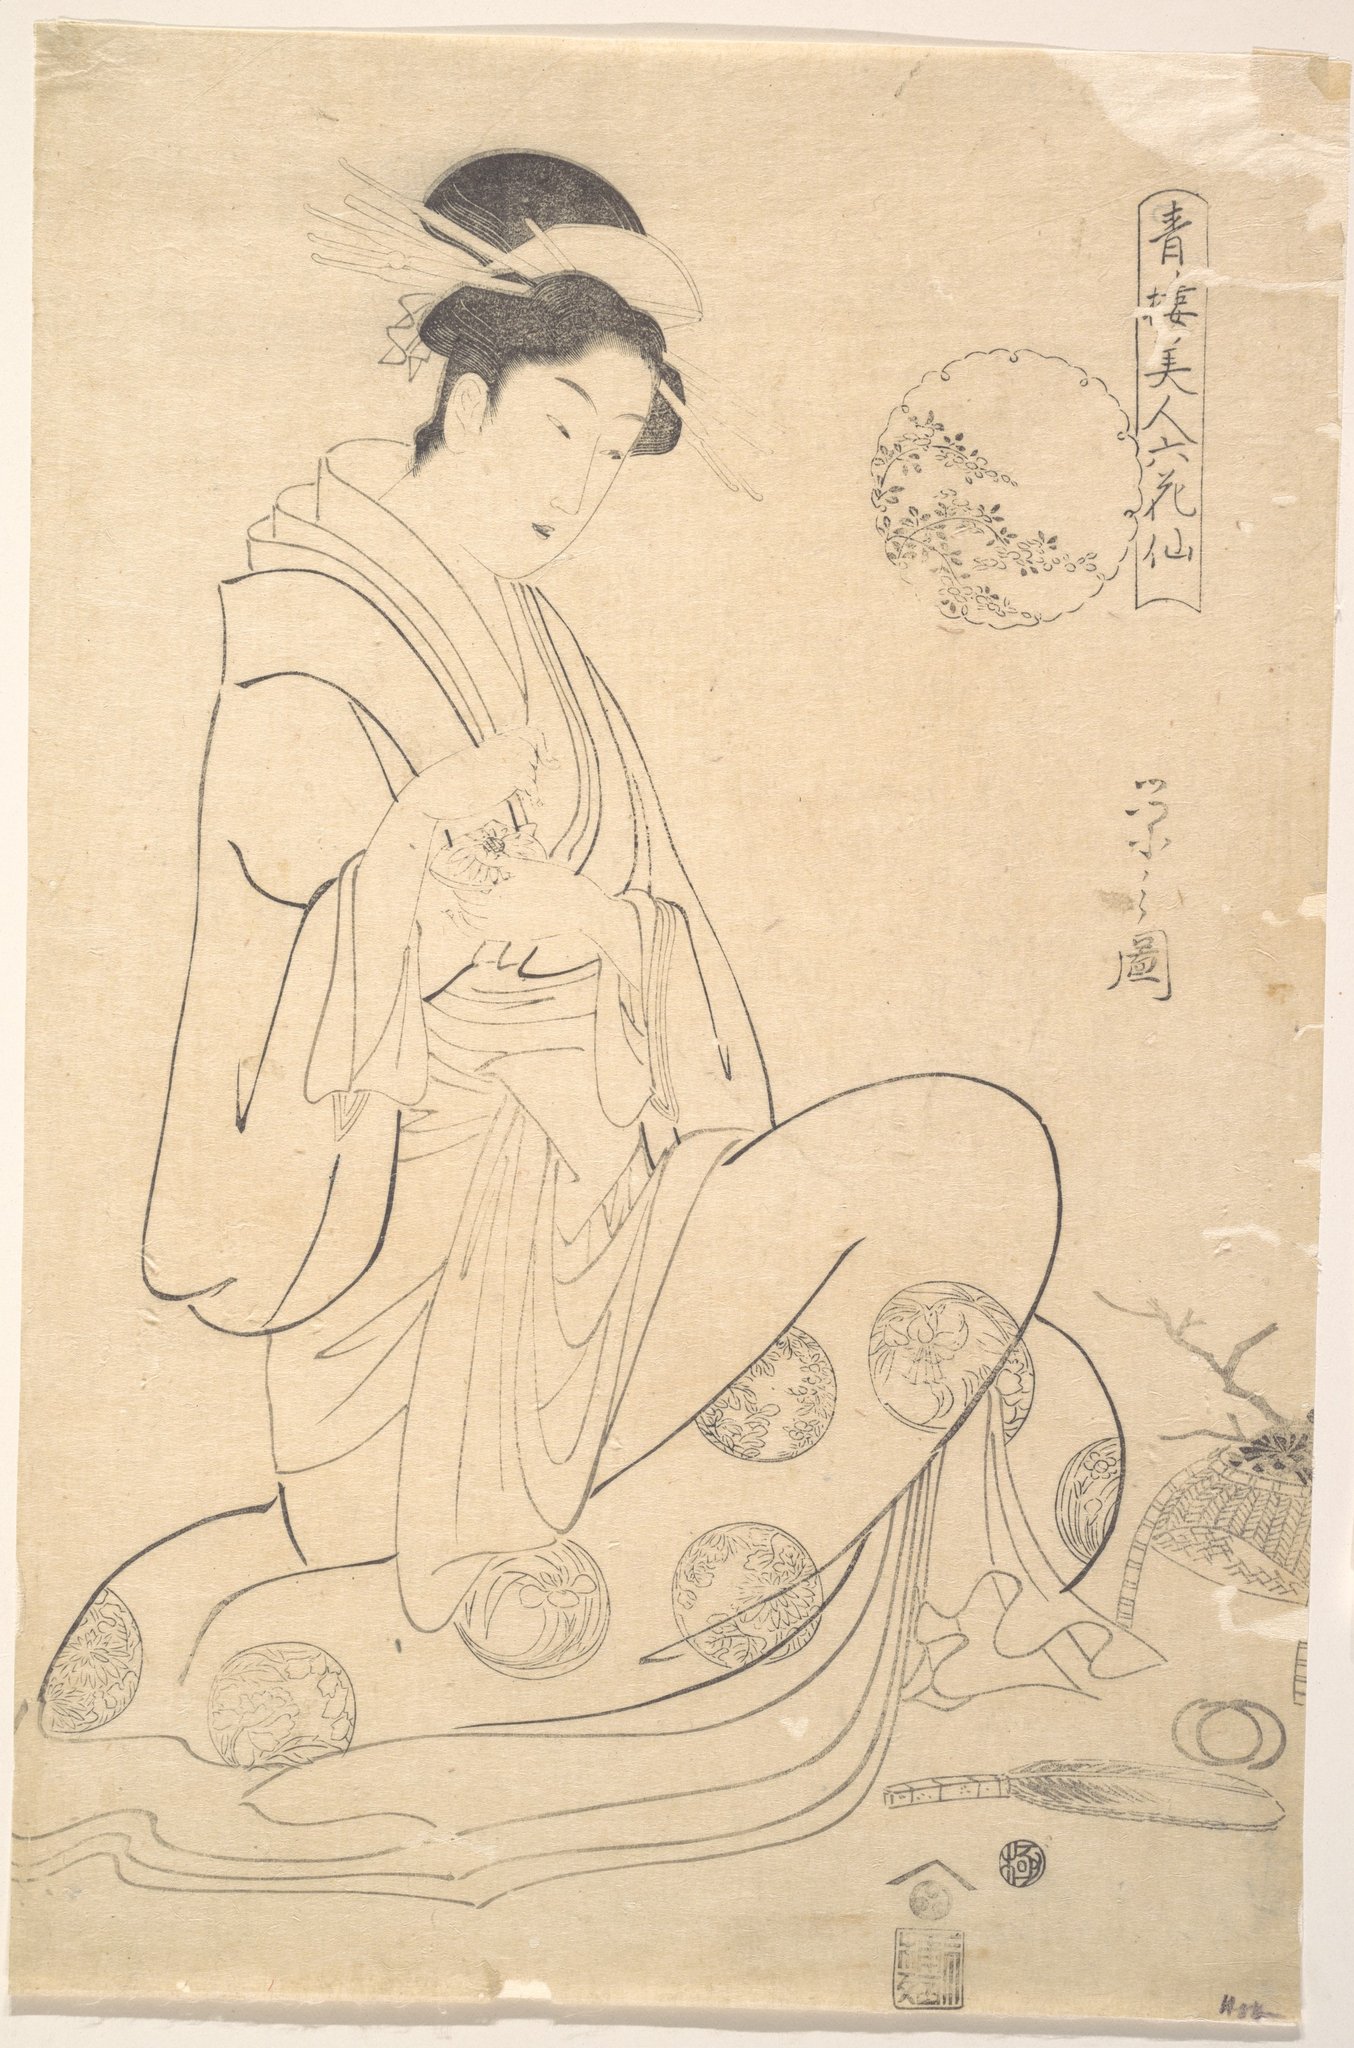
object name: print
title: Konosato of Takeya Seated, Holding an Incense Burner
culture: japanese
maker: chōbunsai eishi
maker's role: artist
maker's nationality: japanese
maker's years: 1756-1829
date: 1756-1829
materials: ink, paper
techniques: woodblock print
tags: women,incense burners